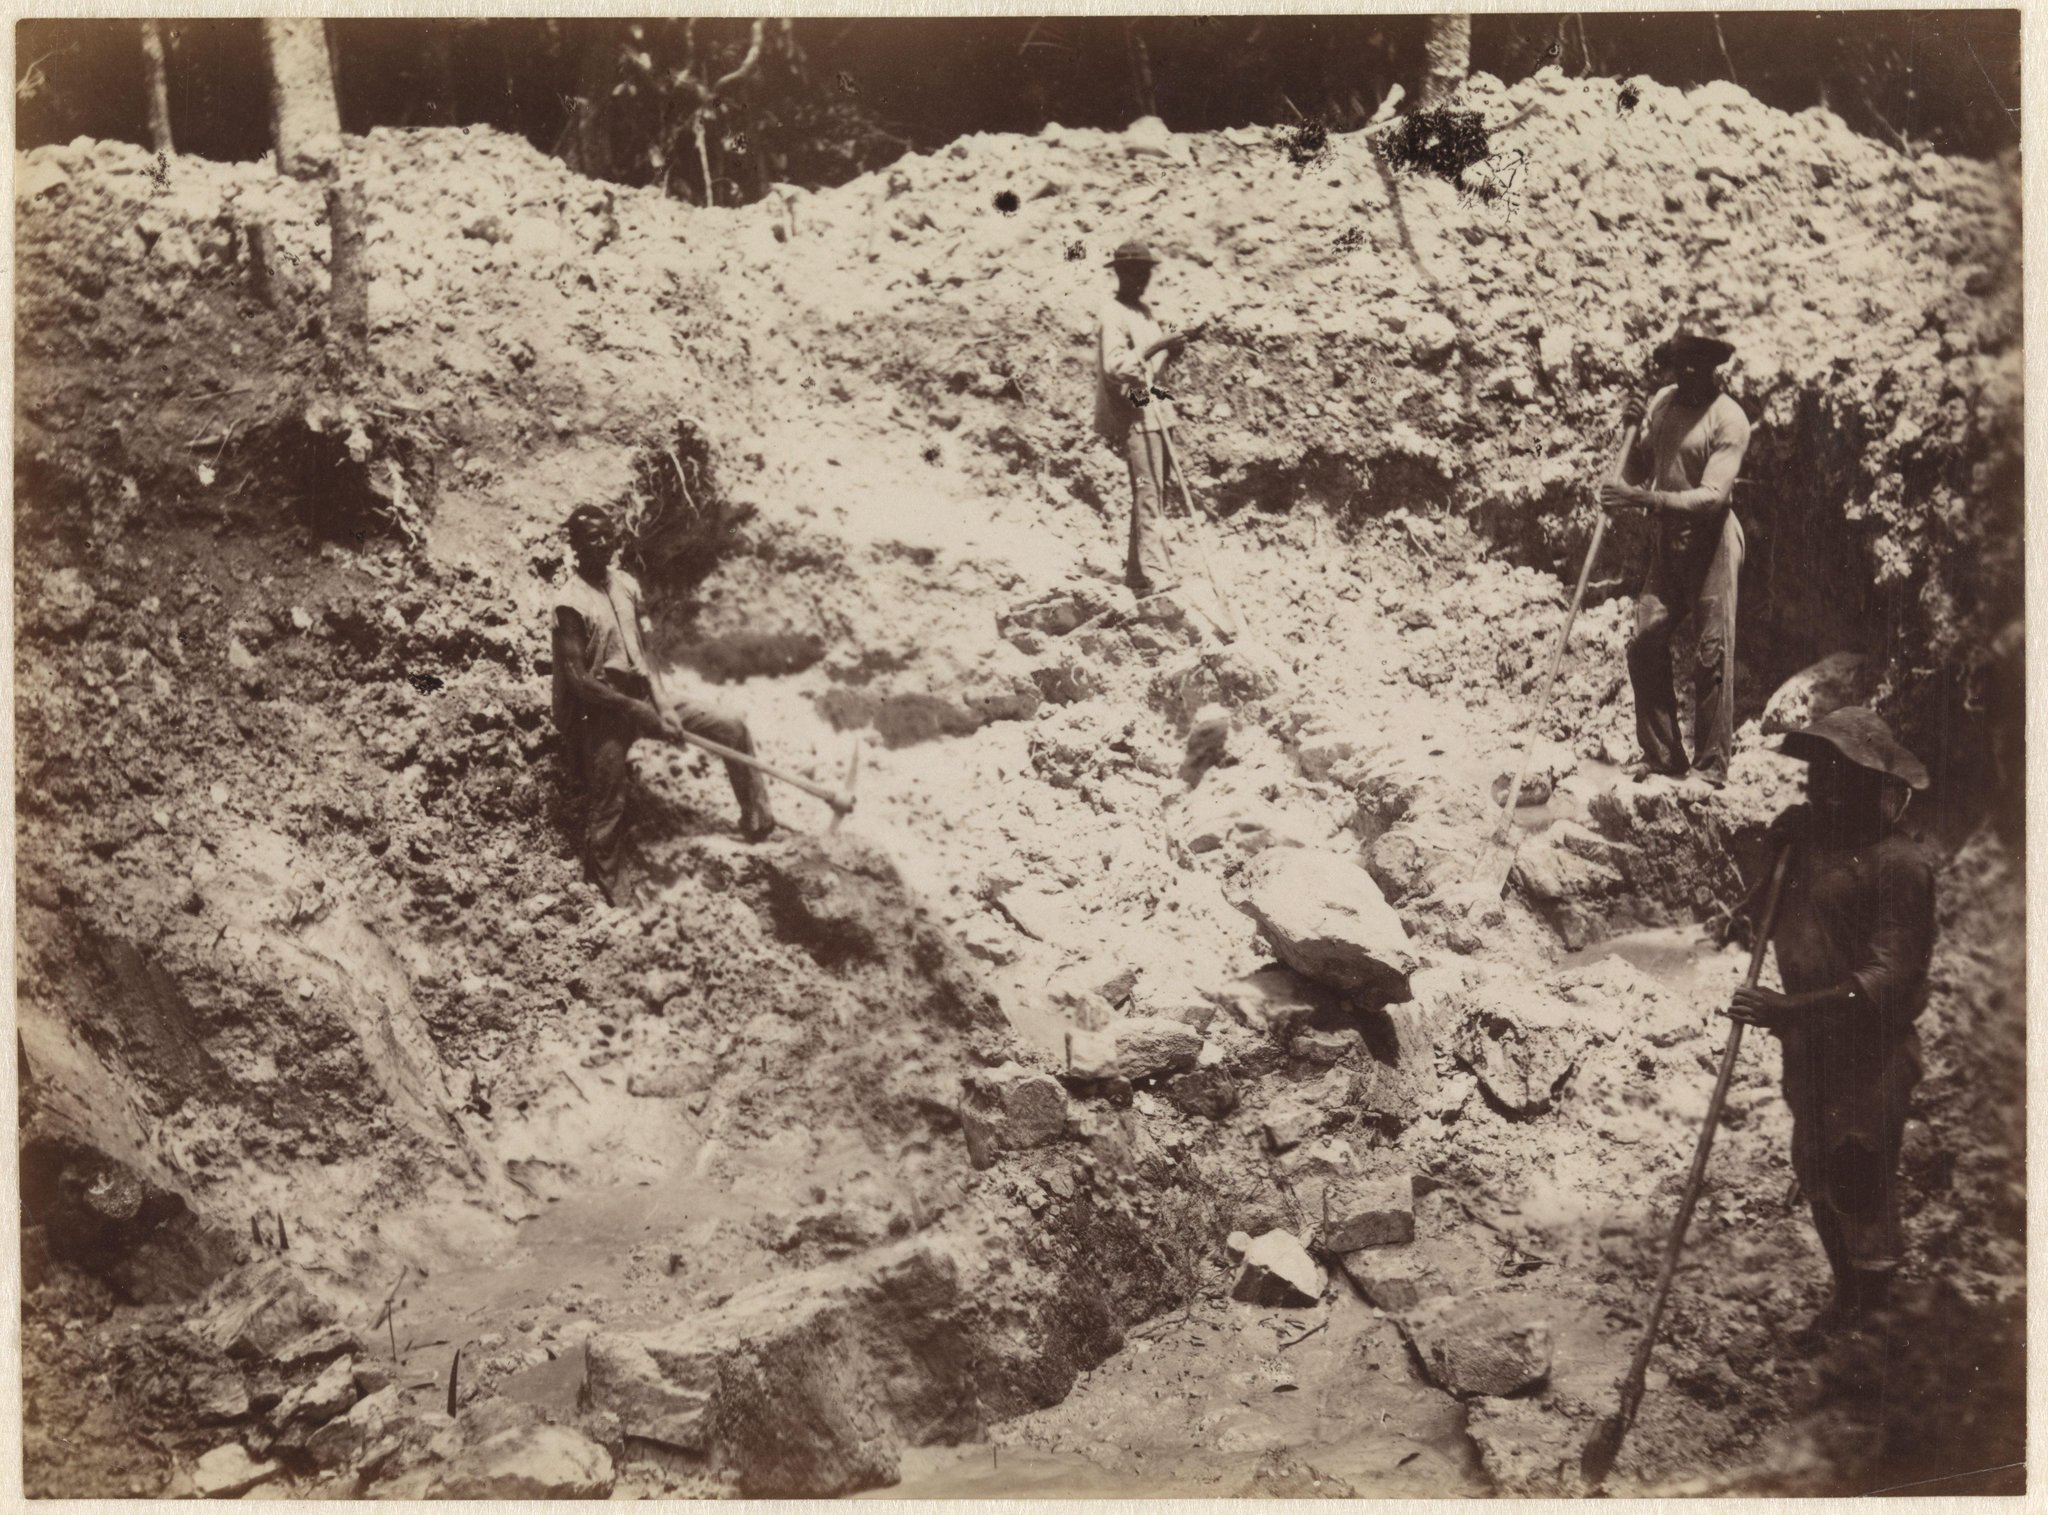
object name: photograph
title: Blootleggen van kwartsriffen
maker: julius muller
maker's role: official, politician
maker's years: 1846-1902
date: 1882-1902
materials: photographic support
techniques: albumen print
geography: suriname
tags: mining, suriname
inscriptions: inscription: ‘Blootleggen van kwartsriffen’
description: Het blootlegen van goudhoudende kwartsriffen ten behoeve van de goudwinning in Oost-Suriname, waarschijnlijk op placer Jeanapau.